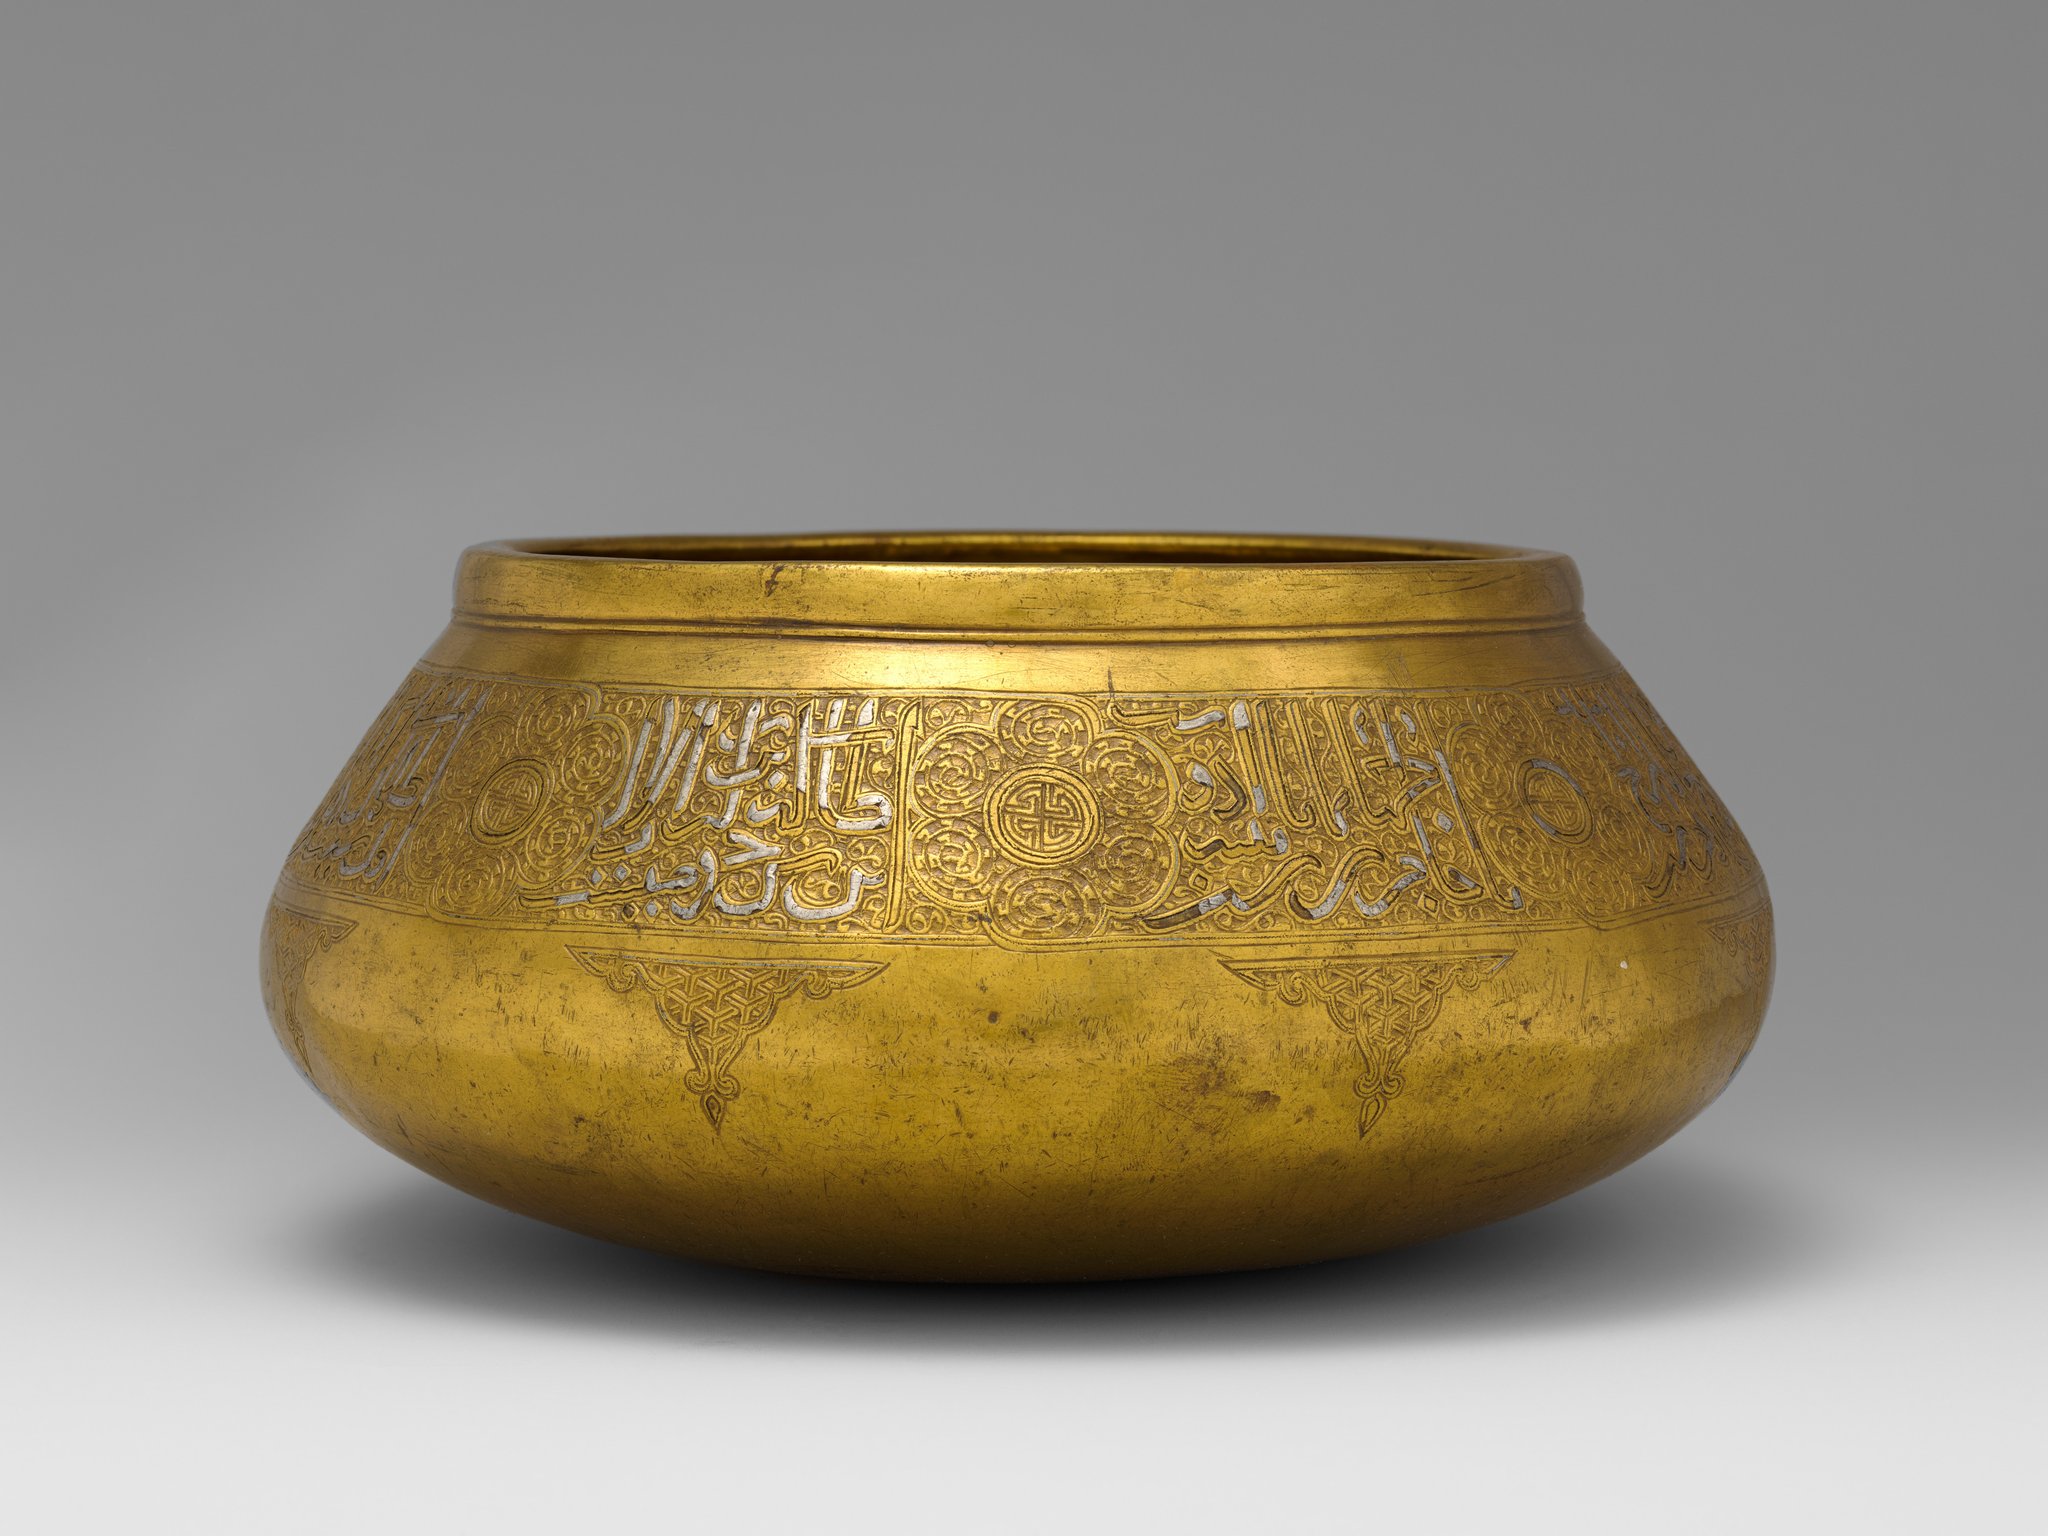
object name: bowl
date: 1334-1366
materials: brass, silver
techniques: engraving, inlay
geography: iran